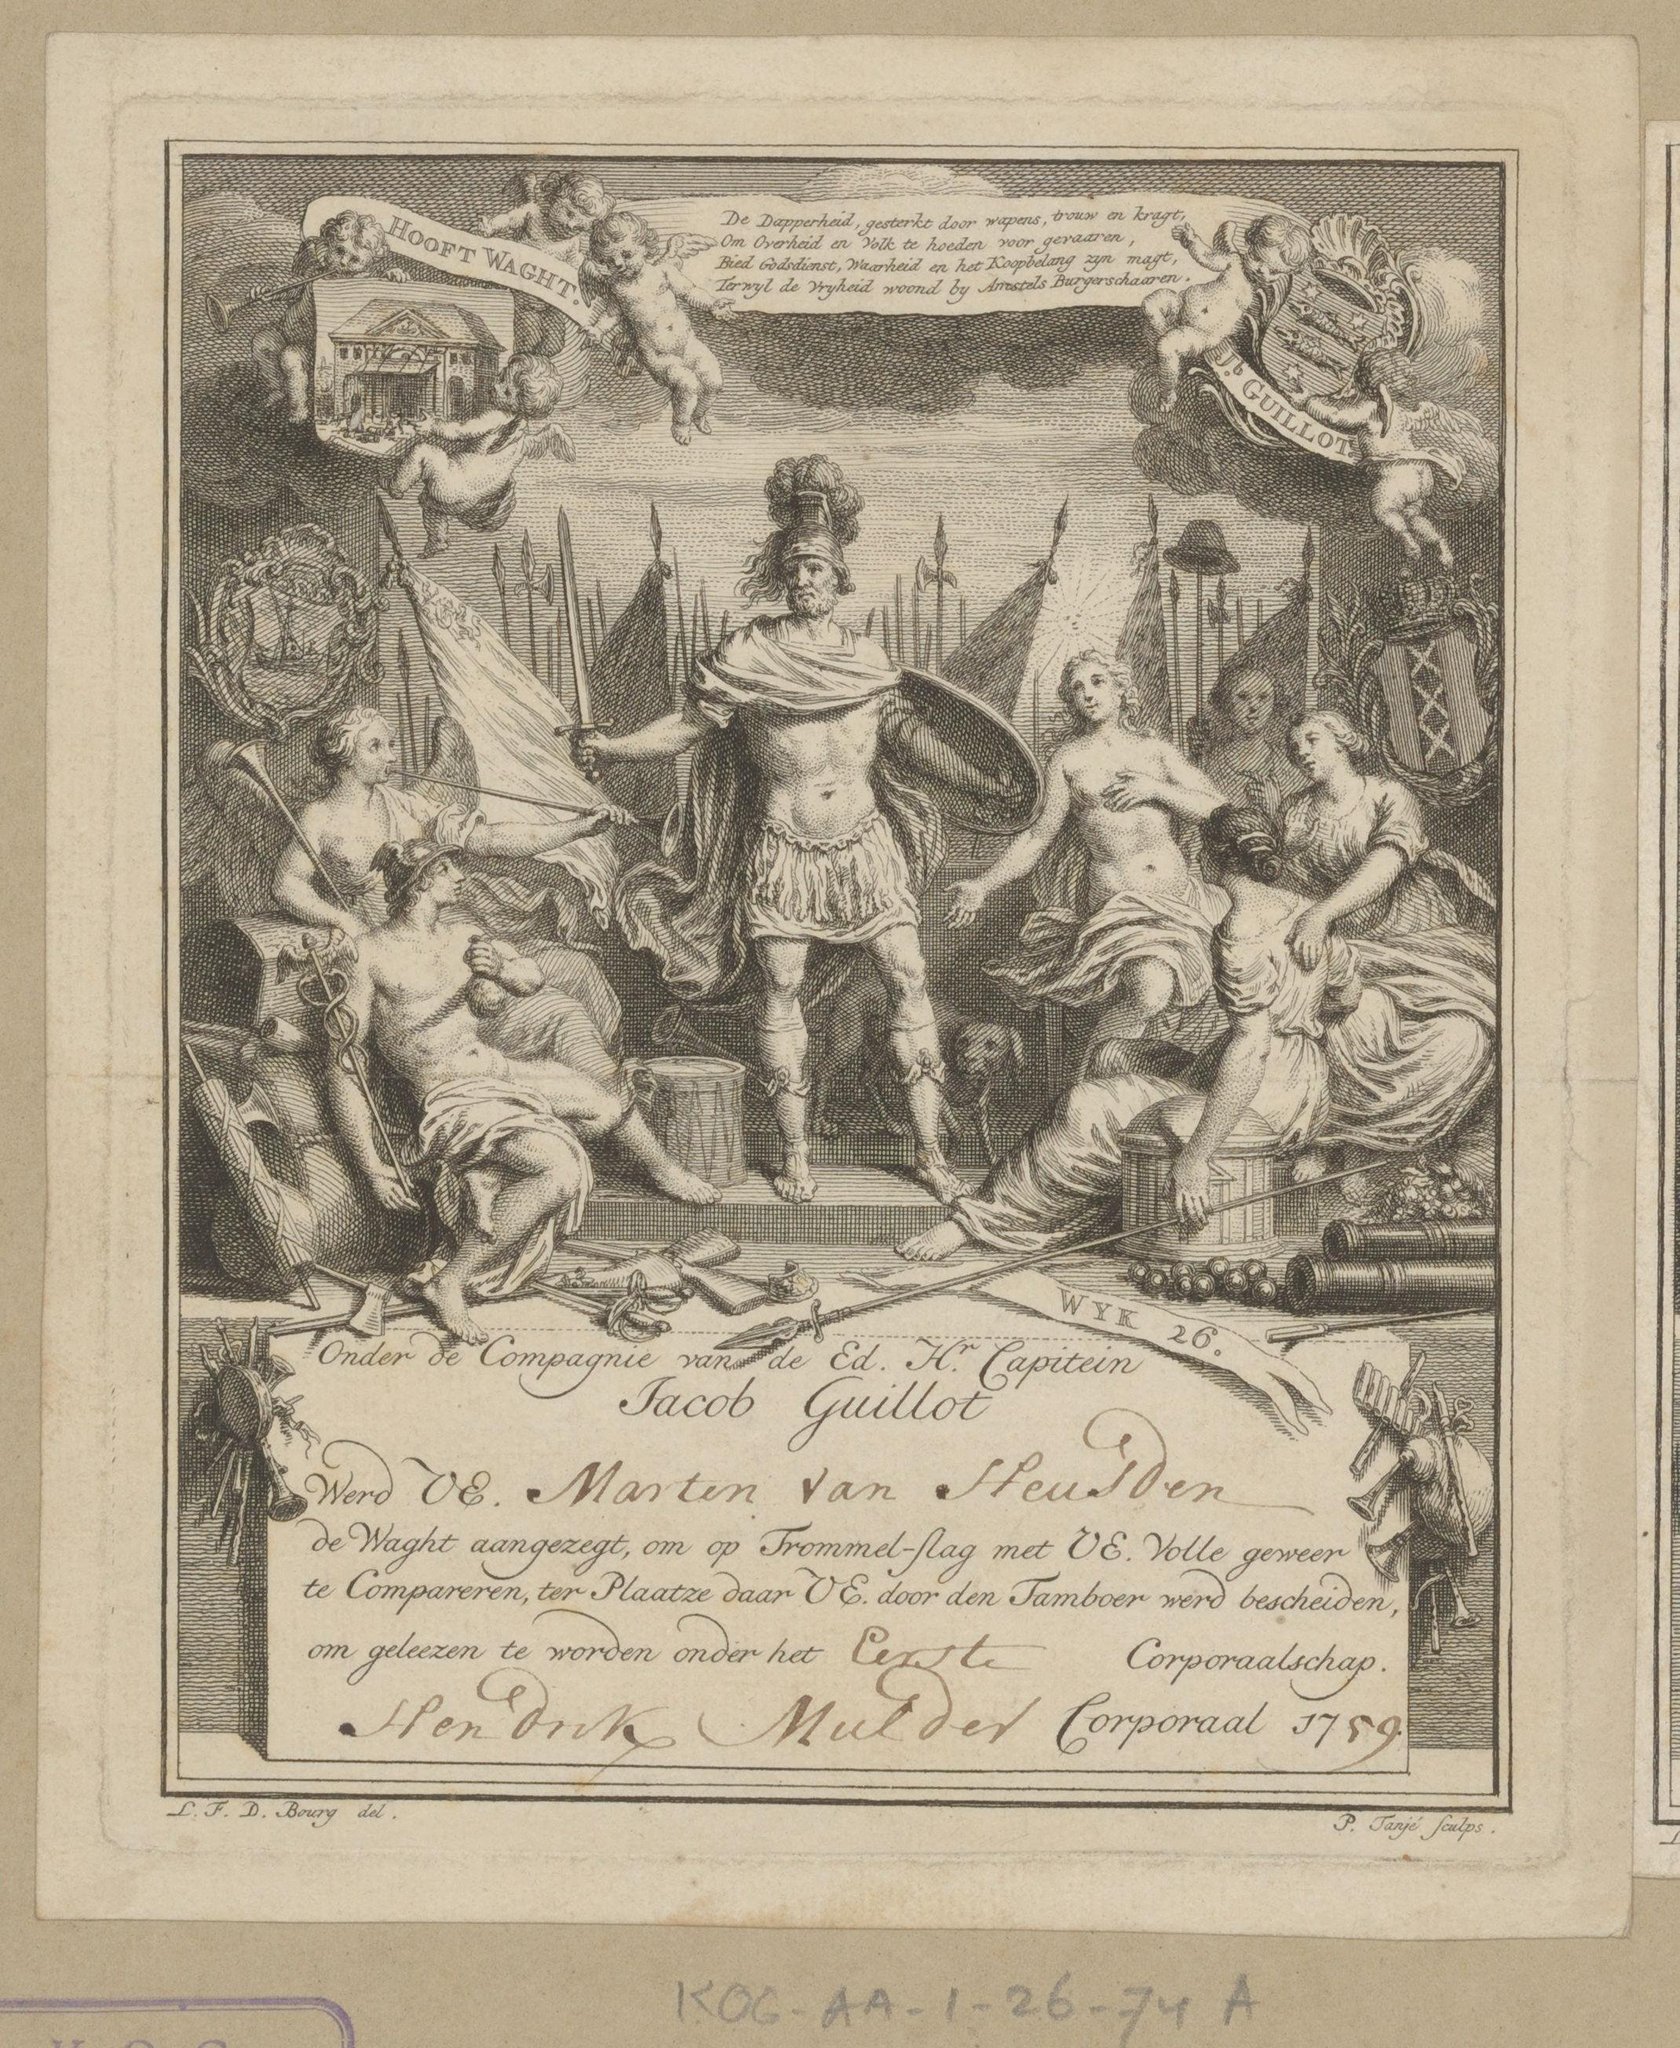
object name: schuttersbiljet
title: Schuttersbrief van kapitein Jacob Guillot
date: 1759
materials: paper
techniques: engraving, etching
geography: amsterdam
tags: coat of arms (as symbol of the state, etc.) (+ city; municipal), freedom, liberty; 'libertà' (ripa), allegory of trade; 'commertio della vita humana' (ripa), armorial bearing, heraldry, courage, bravery, valiance, manliness; 'ardire magnanimo et generoso', 'gagliardezza', 'valore', 'virtù heroica', 'virtù dell'animo e del corpo' (ripa), amsterdam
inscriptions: collector's mark: Lugt 1641b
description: Schuttersbrief met oproep van kapitein Jacob Guillot, gericht aan Marten van Heusden, om zich bij het eerste korporaalschap van Hendrik Mulder van burgerwijk XXVI te Amsterdam te melden. Voorgedrukte brief met open delen die met pen zijn ingevuld. Onderwerpsrubriek binnen de Atlas Amsterdam: Schutters-oproepingsbriefjes.